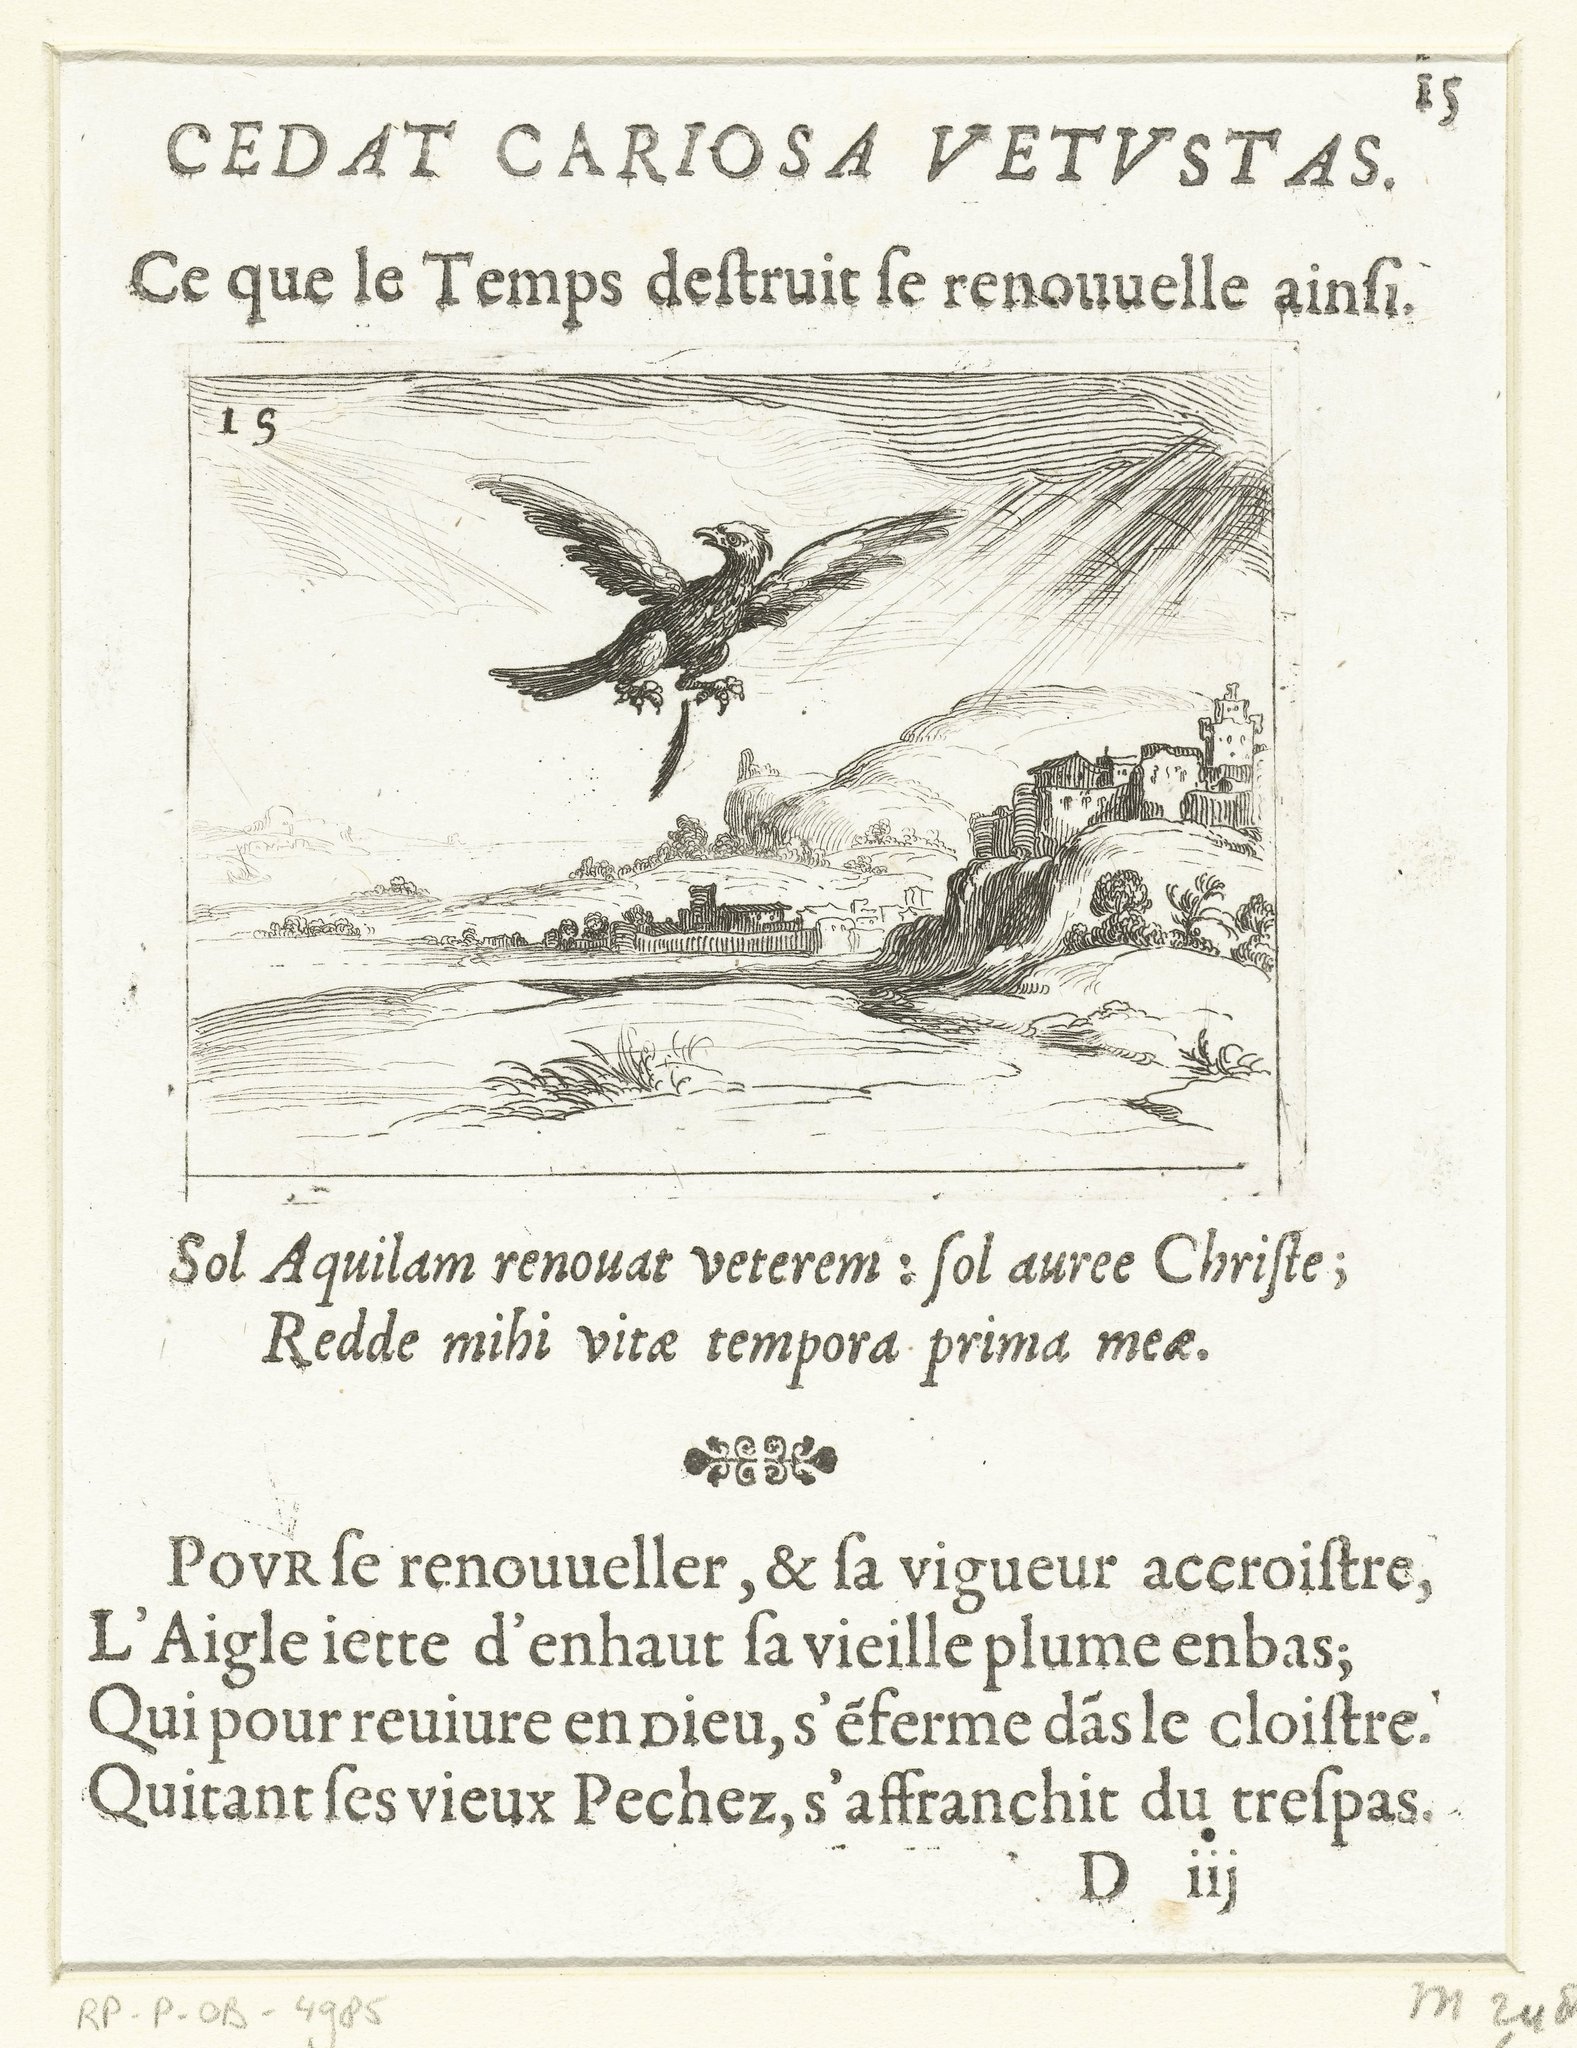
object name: print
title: Kloosterleven in emblemen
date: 1621-1635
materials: paper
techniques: etching, letterpress printing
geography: nancy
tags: predatory birds: eagle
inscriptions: collector's mark: Lugt 240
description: Voorstelling van een adelaar die al vliegend een veer laat vallen. Boven en onder deze prent Latijnse en Franse teksten in boekdruk. Dit blad is onderdeel van de embleemserie 'Kloosterleven in emblemen'. De tweede staat van deze serie behelst naast een geïllustreerde titelpagina en 26 emblemen nog een titelpagina en een blad met opdracht, beide in boekdruk zonder afbeelding.